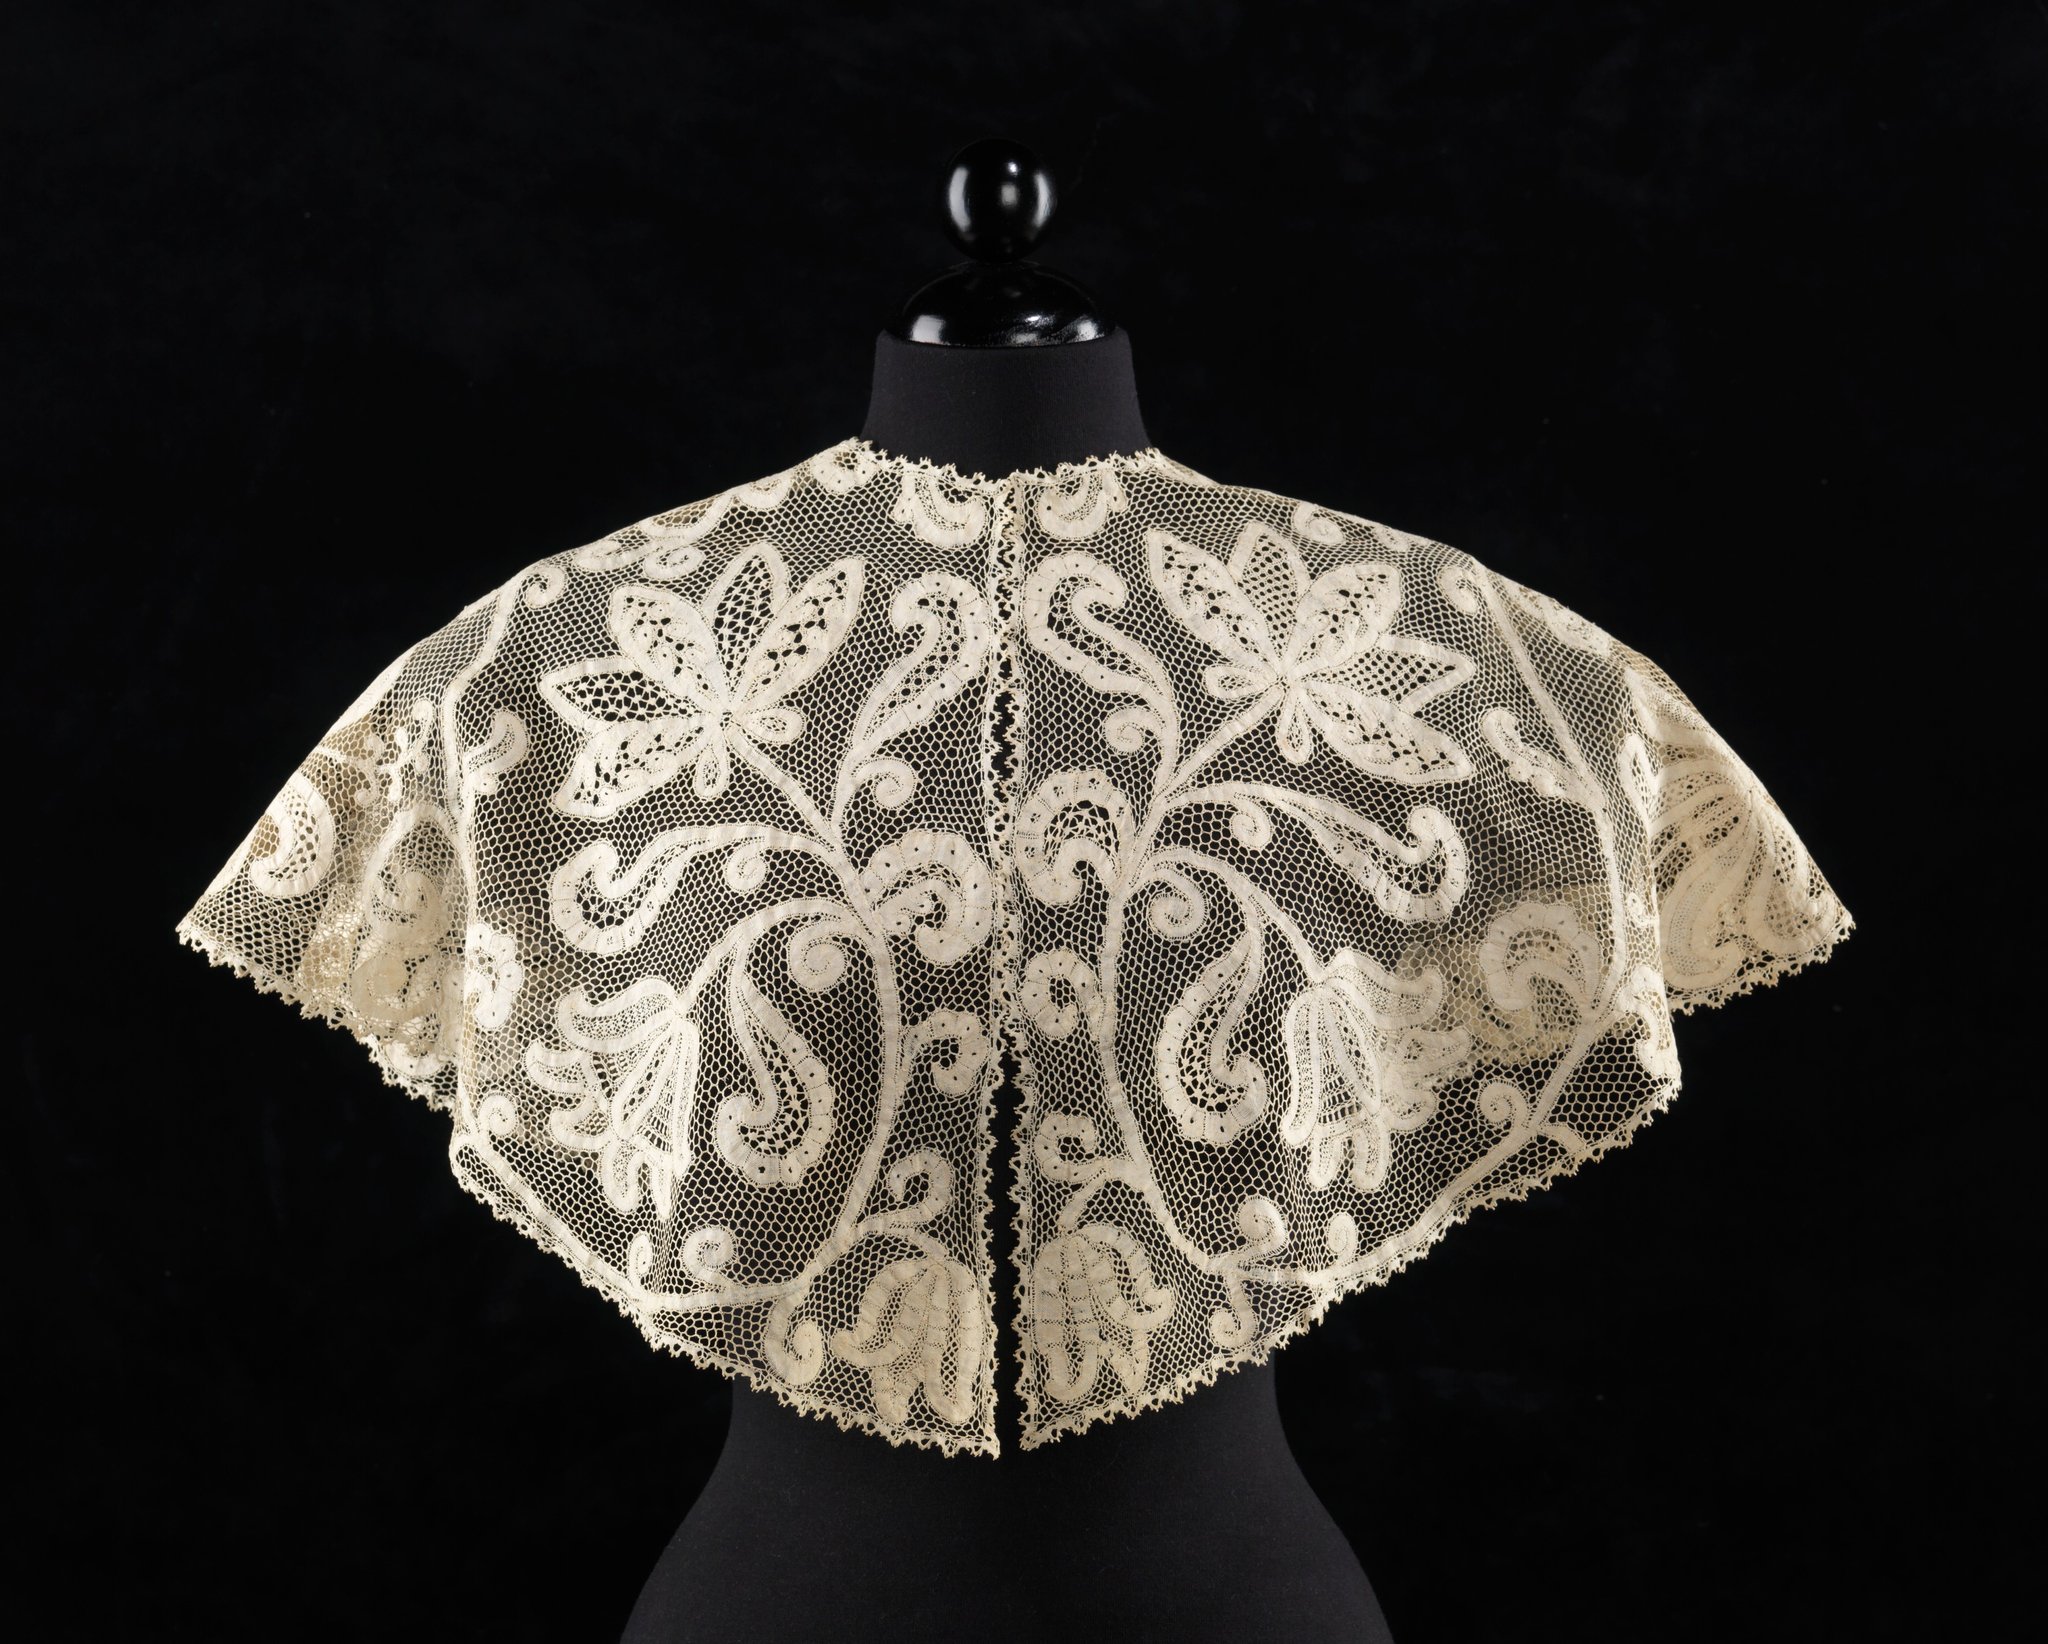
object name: collar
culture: italian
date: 1890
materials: linen